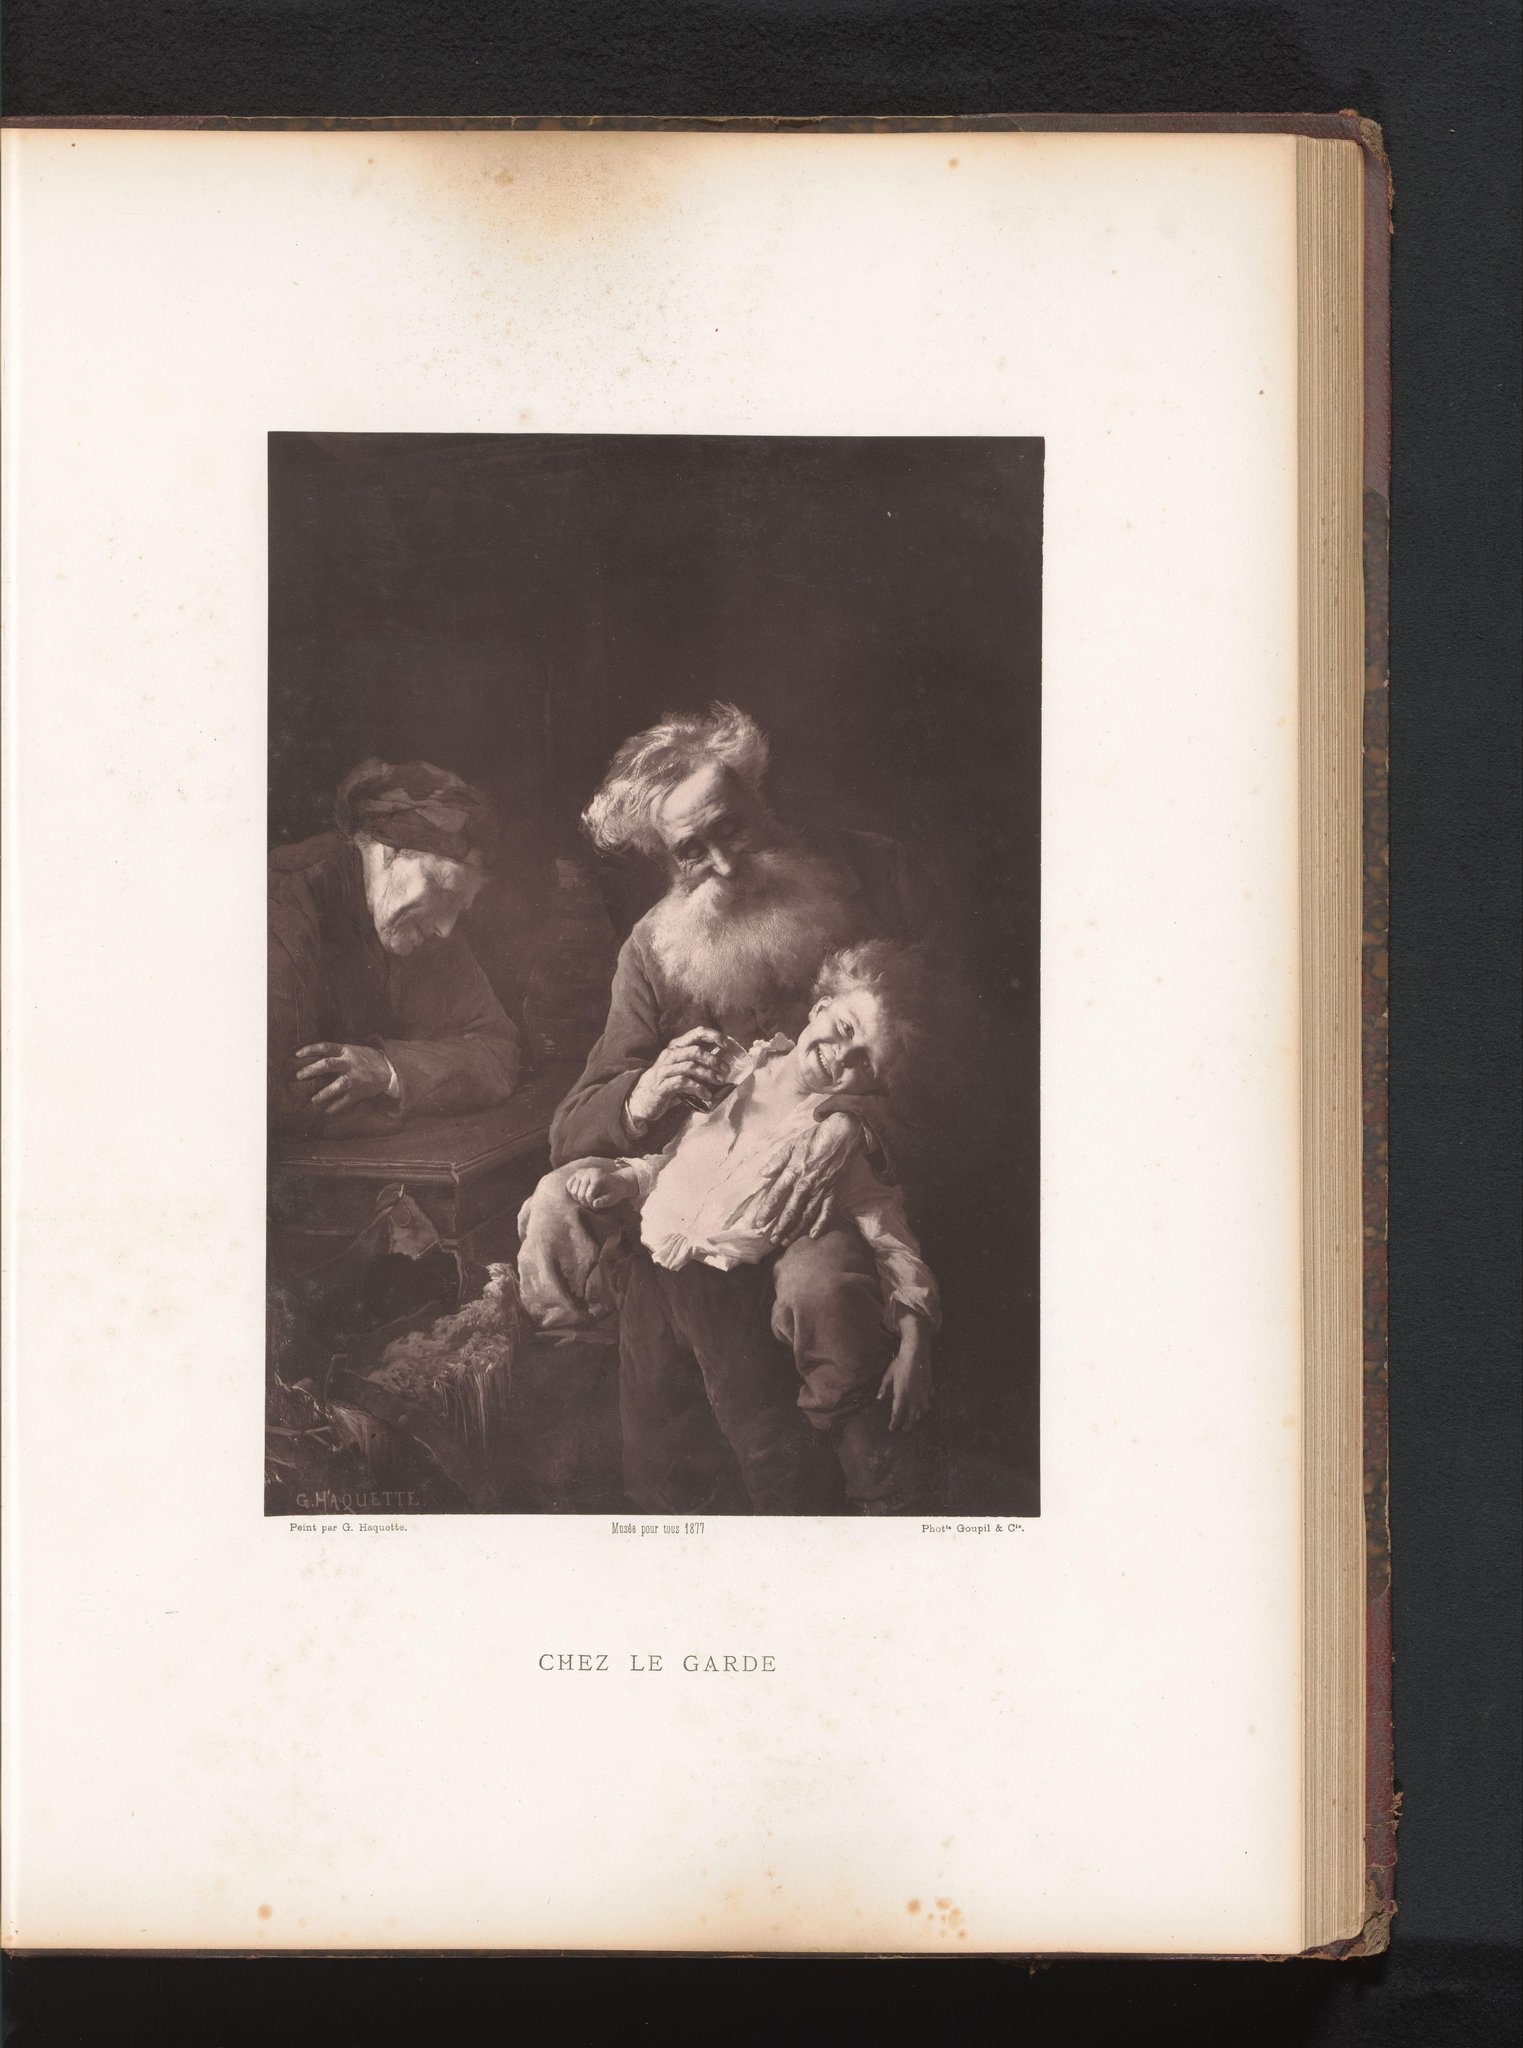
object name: photomechanical print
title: Chez le garde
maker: georges jean marie haquette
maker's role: painter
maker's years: 1853-1906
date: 1872-1879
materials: paper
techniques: woodburytype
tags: the naughty child, glass of wine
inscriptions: inscription: ‘Musée pour tous 1877’